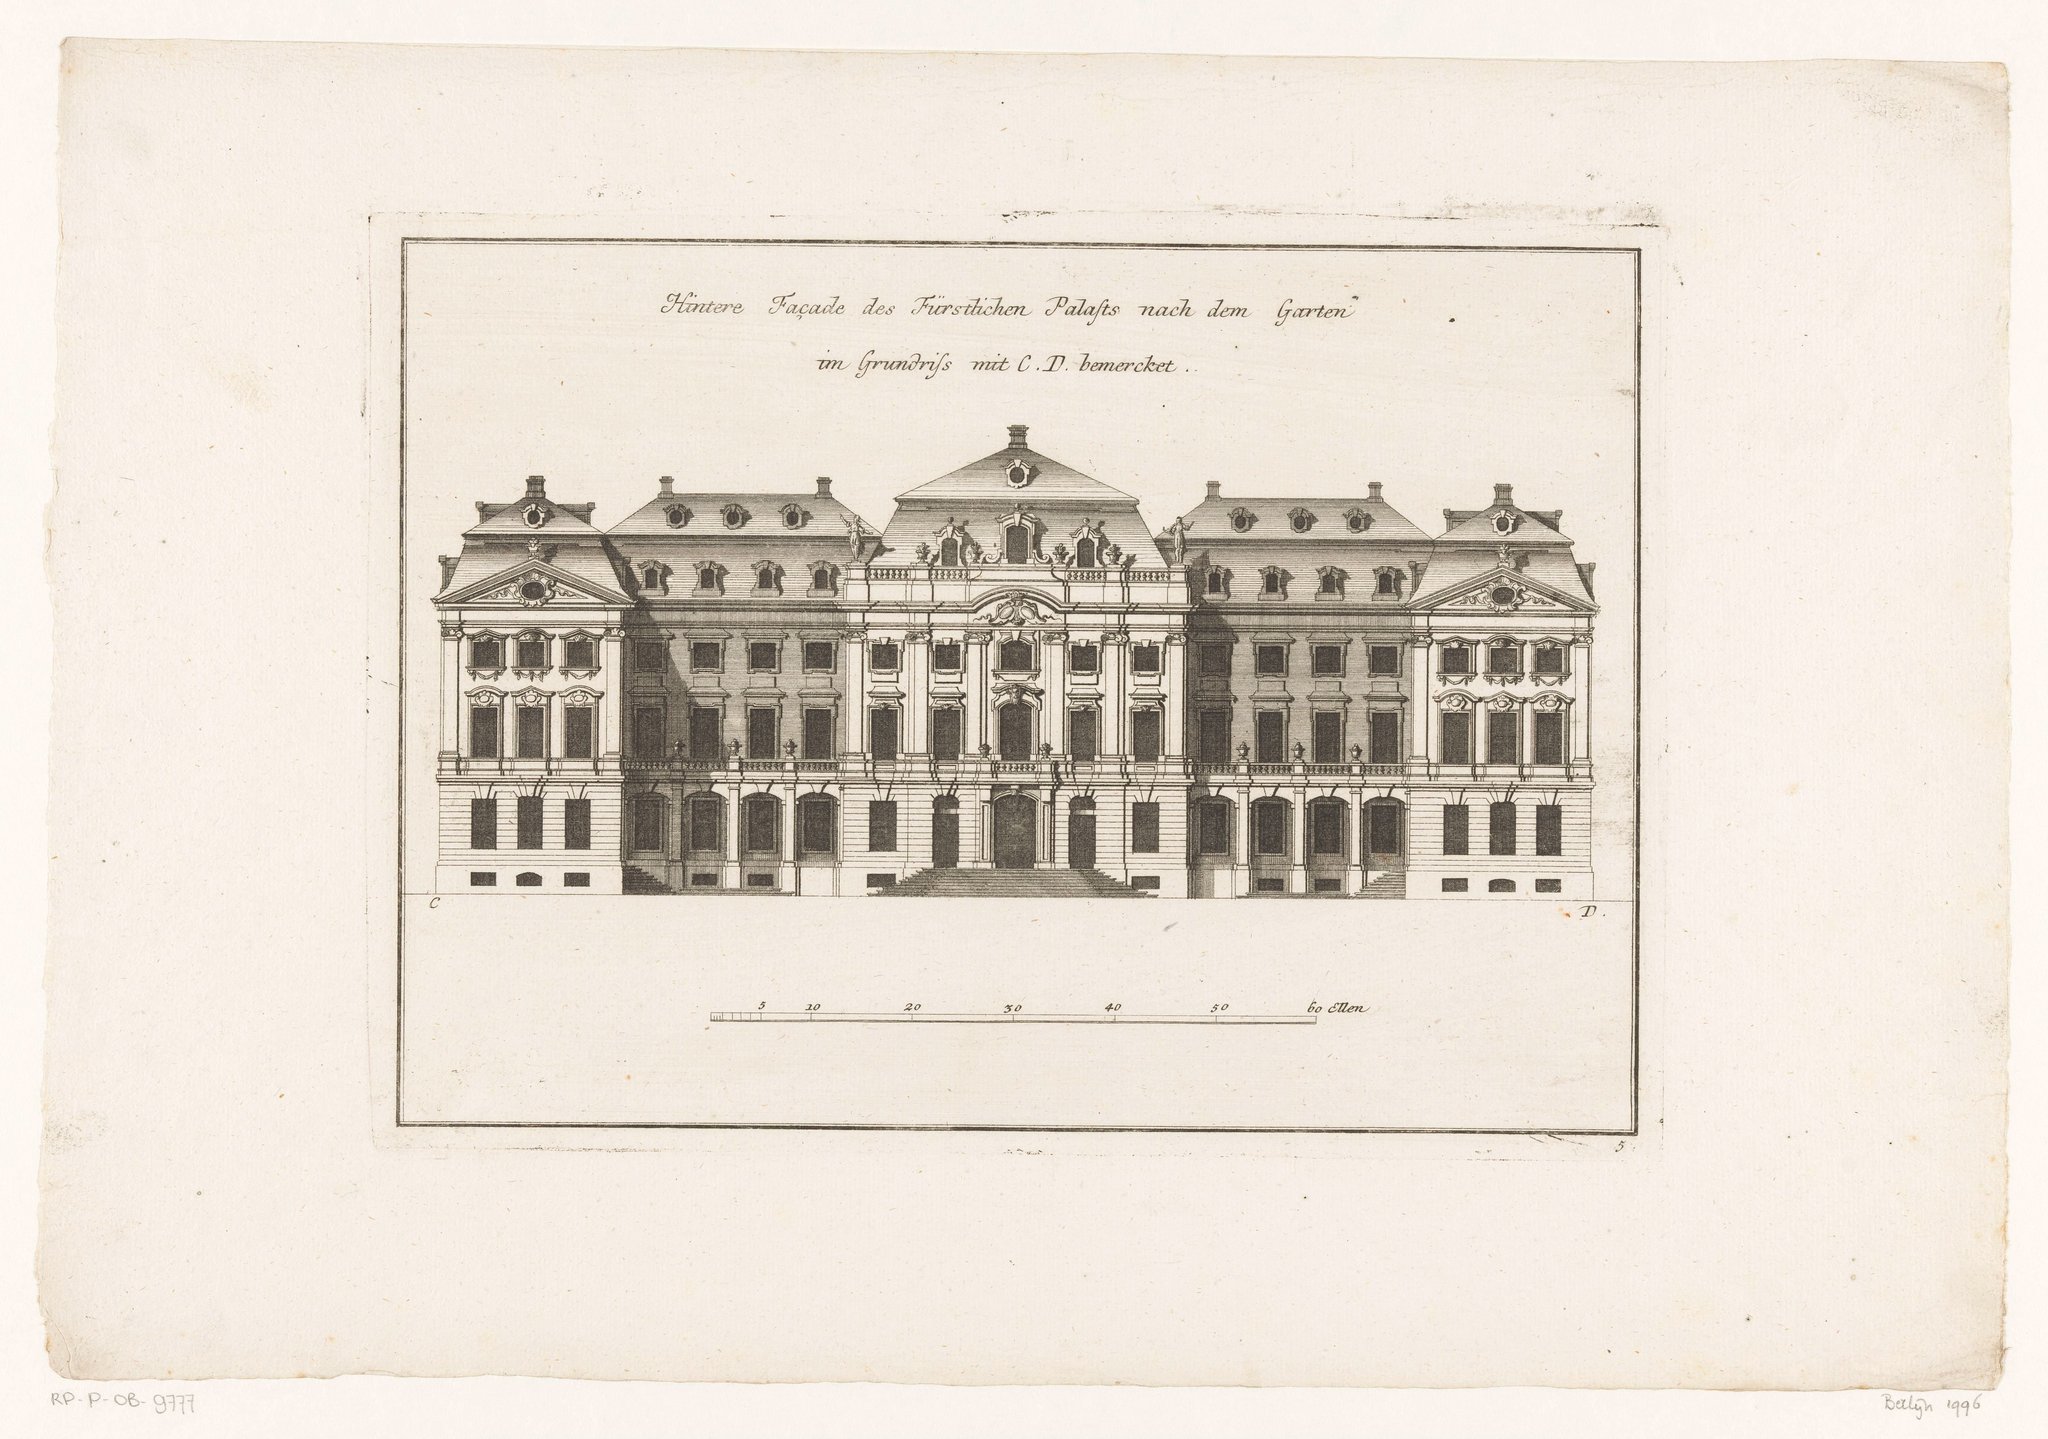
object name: ornament print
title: Achterfaçade van een vorstelijk paleis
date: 1729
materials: paper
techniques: engraving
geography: dresden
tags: rear façade, palace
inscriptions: collector's mark: Lugt 2228